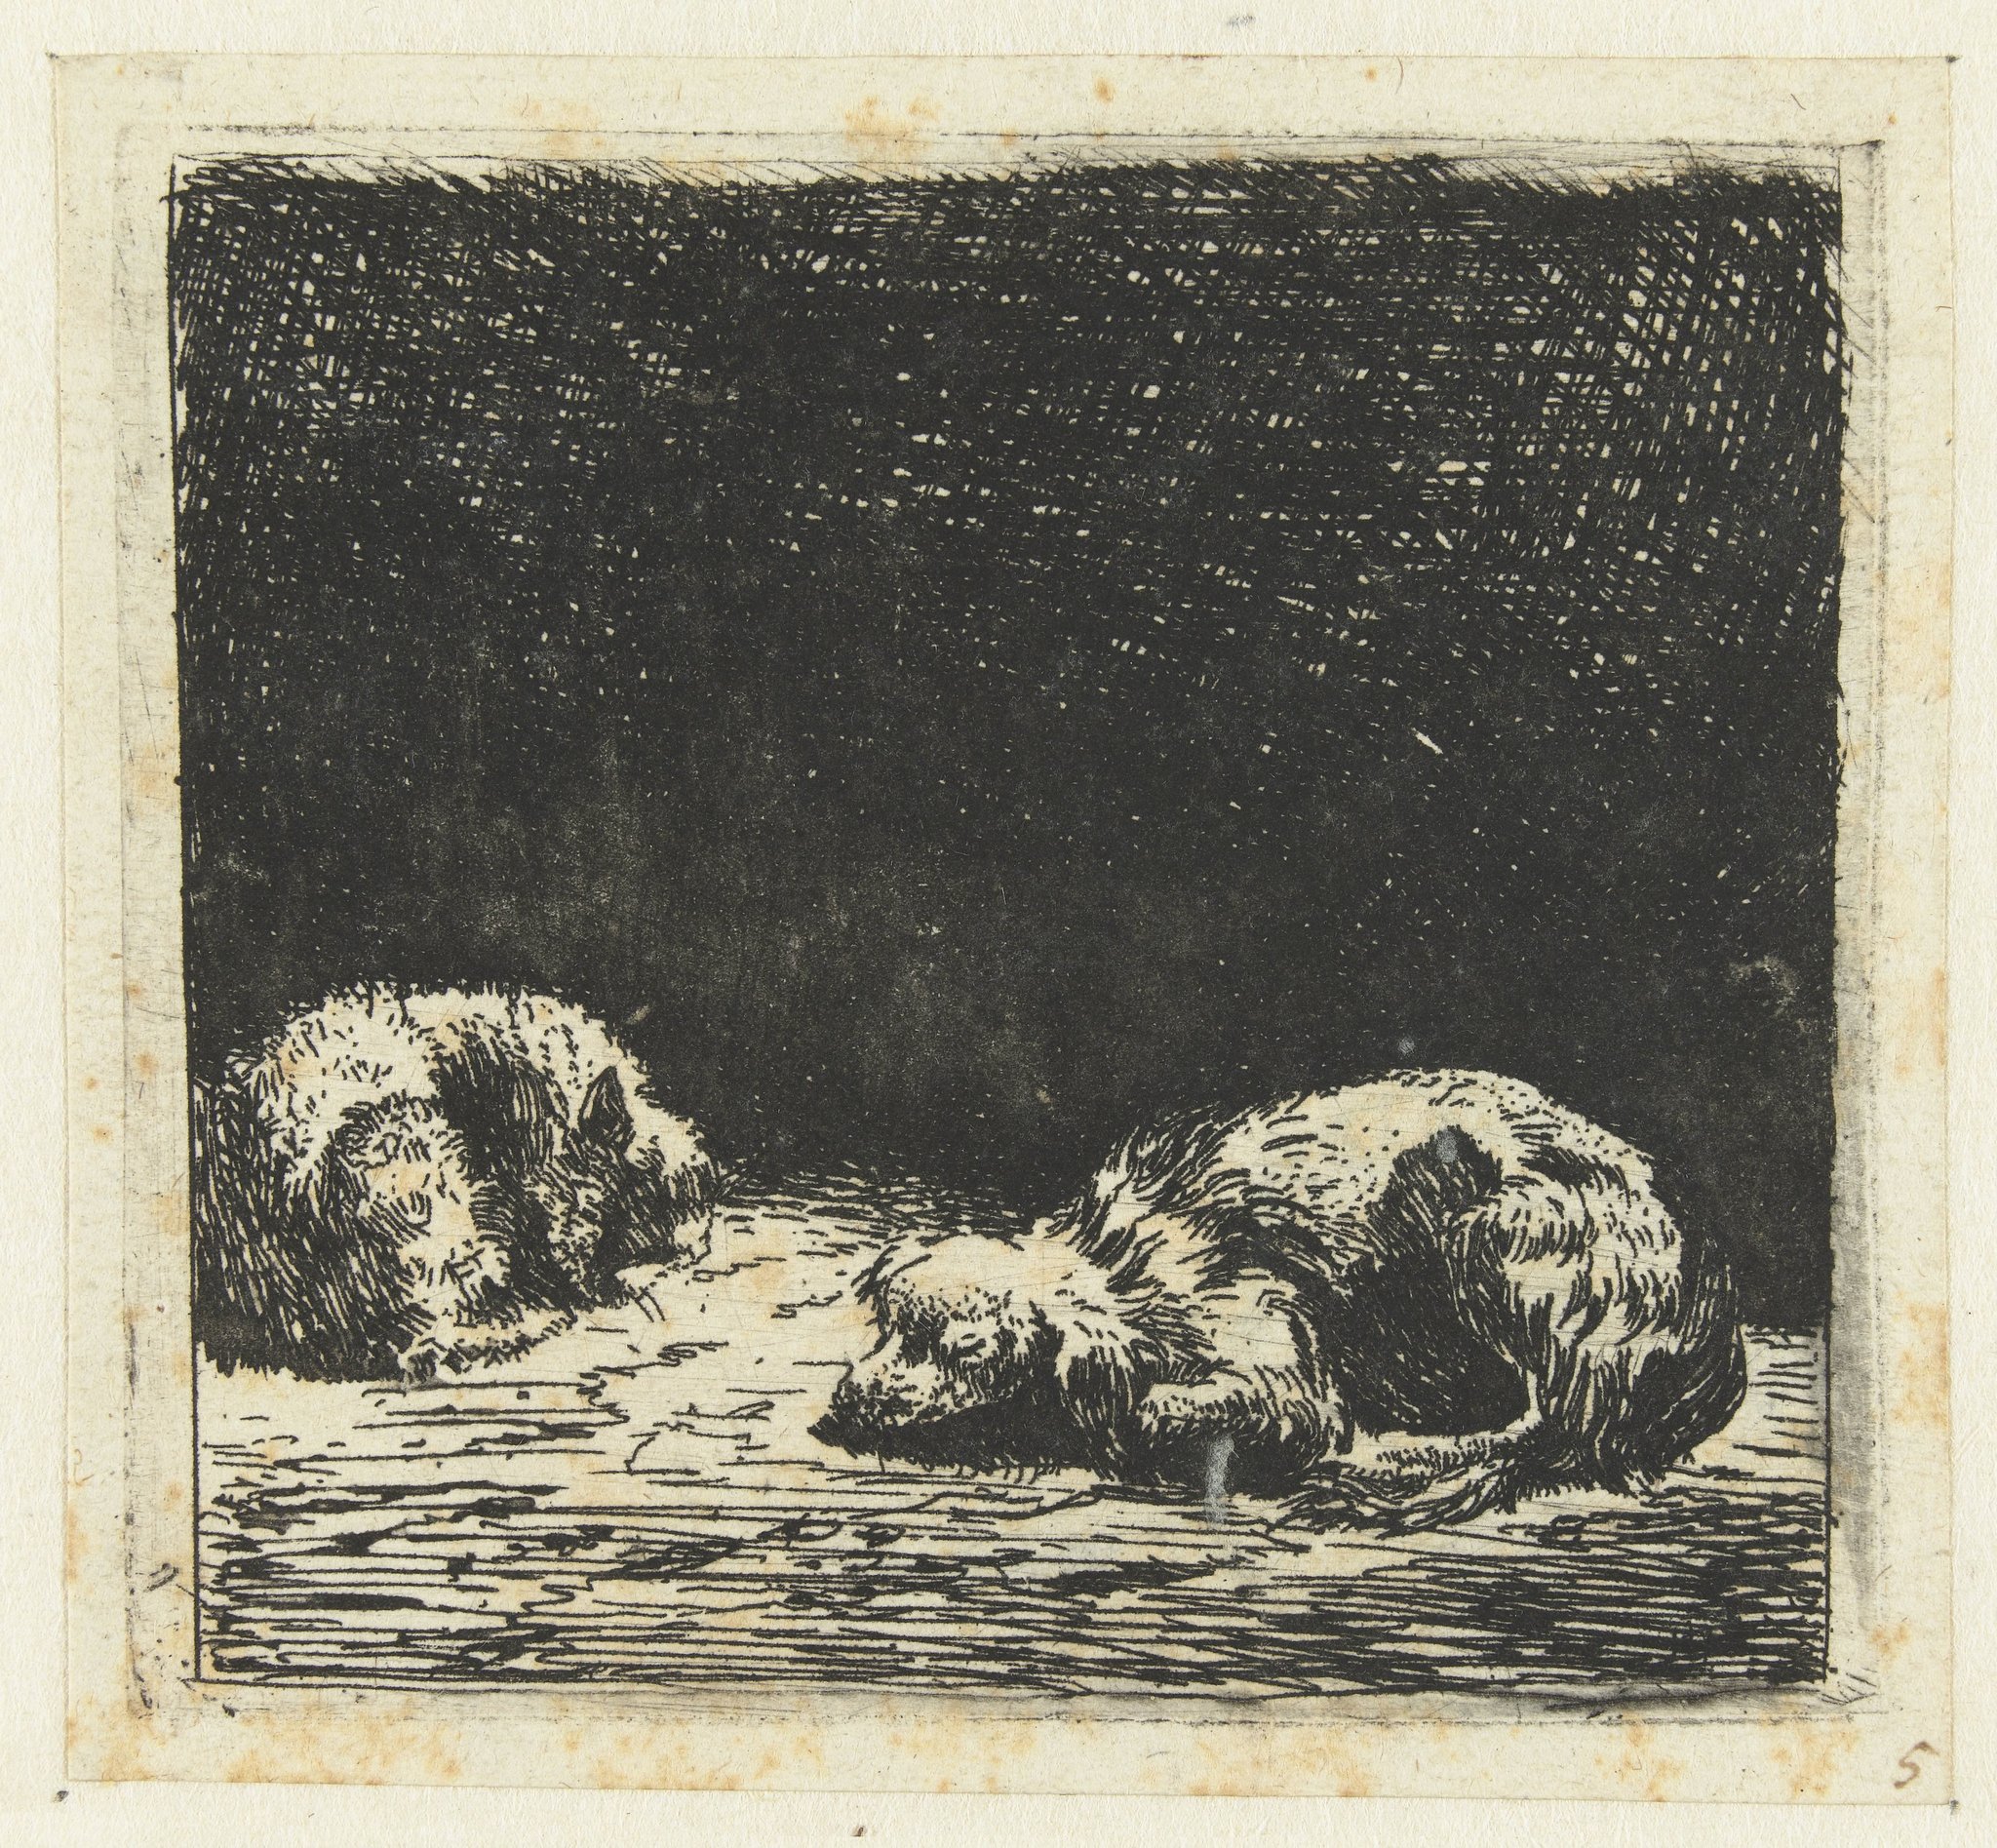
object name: print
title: Slapende hond en kat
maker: karel du jardin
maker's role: draughtsman, painter, print maker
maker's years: 1626-1678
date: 1652-1659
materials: paper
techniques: etching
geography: netherlands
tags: cat, dog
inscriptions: collector's mark: ‘Hinloopen’ Lugt 11, collector's mark: Lugt 10